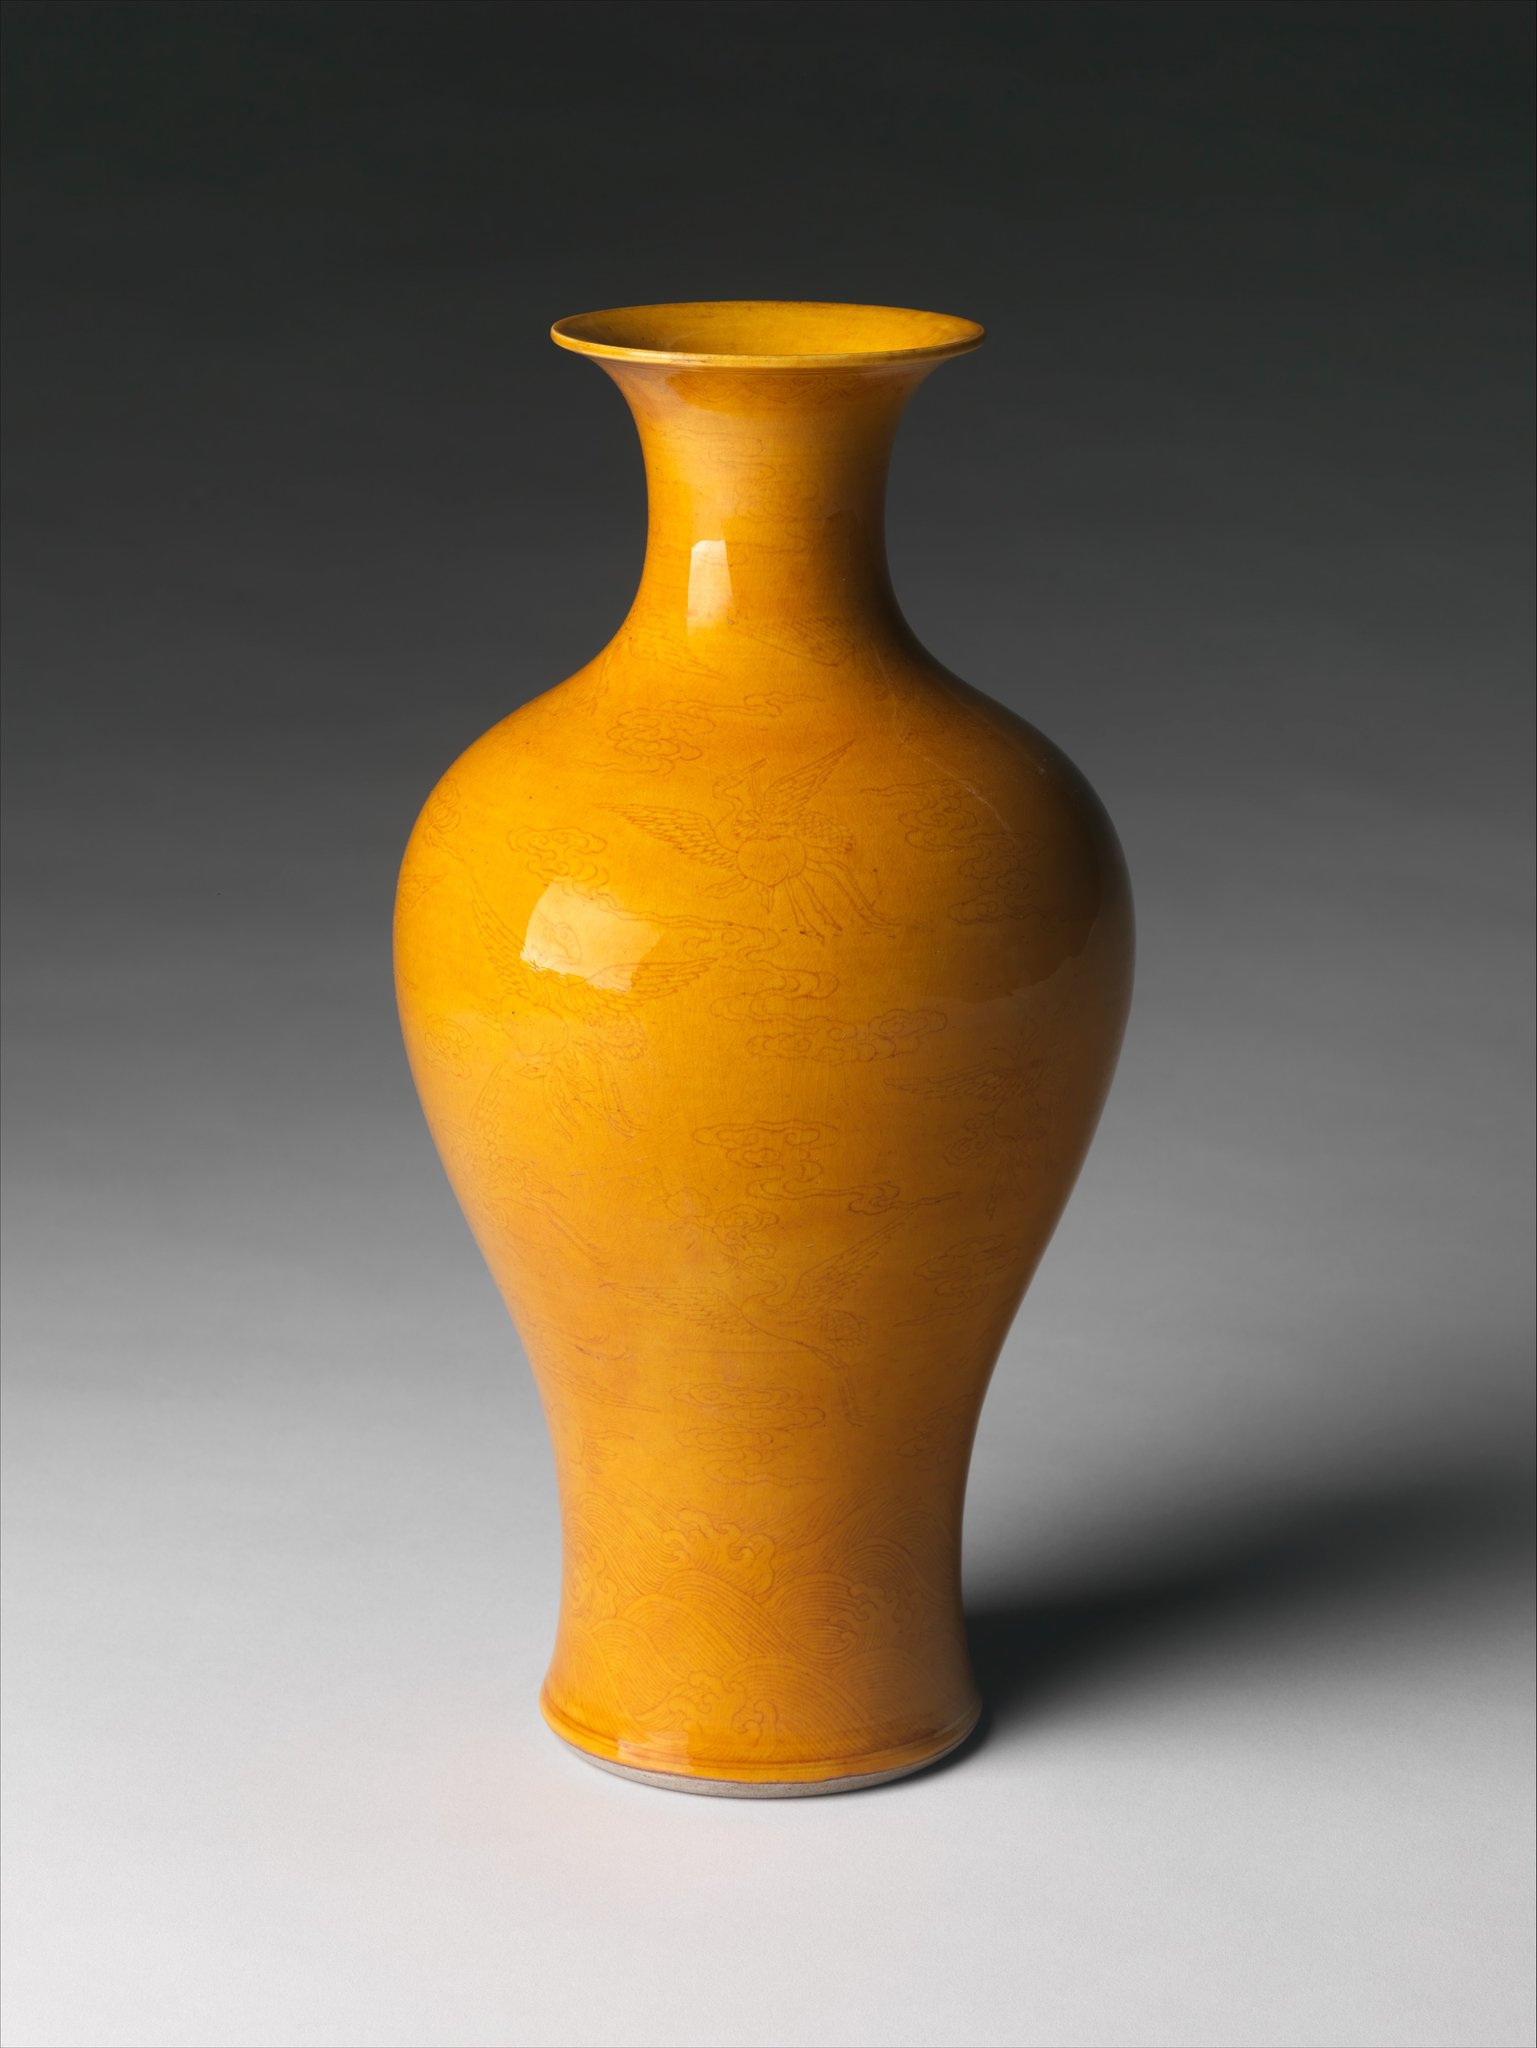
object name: vase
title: Vase with Cranes, Clouds, and Waves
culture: chinese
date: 1767-1800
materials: amber, glaze, porcelain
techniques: incising